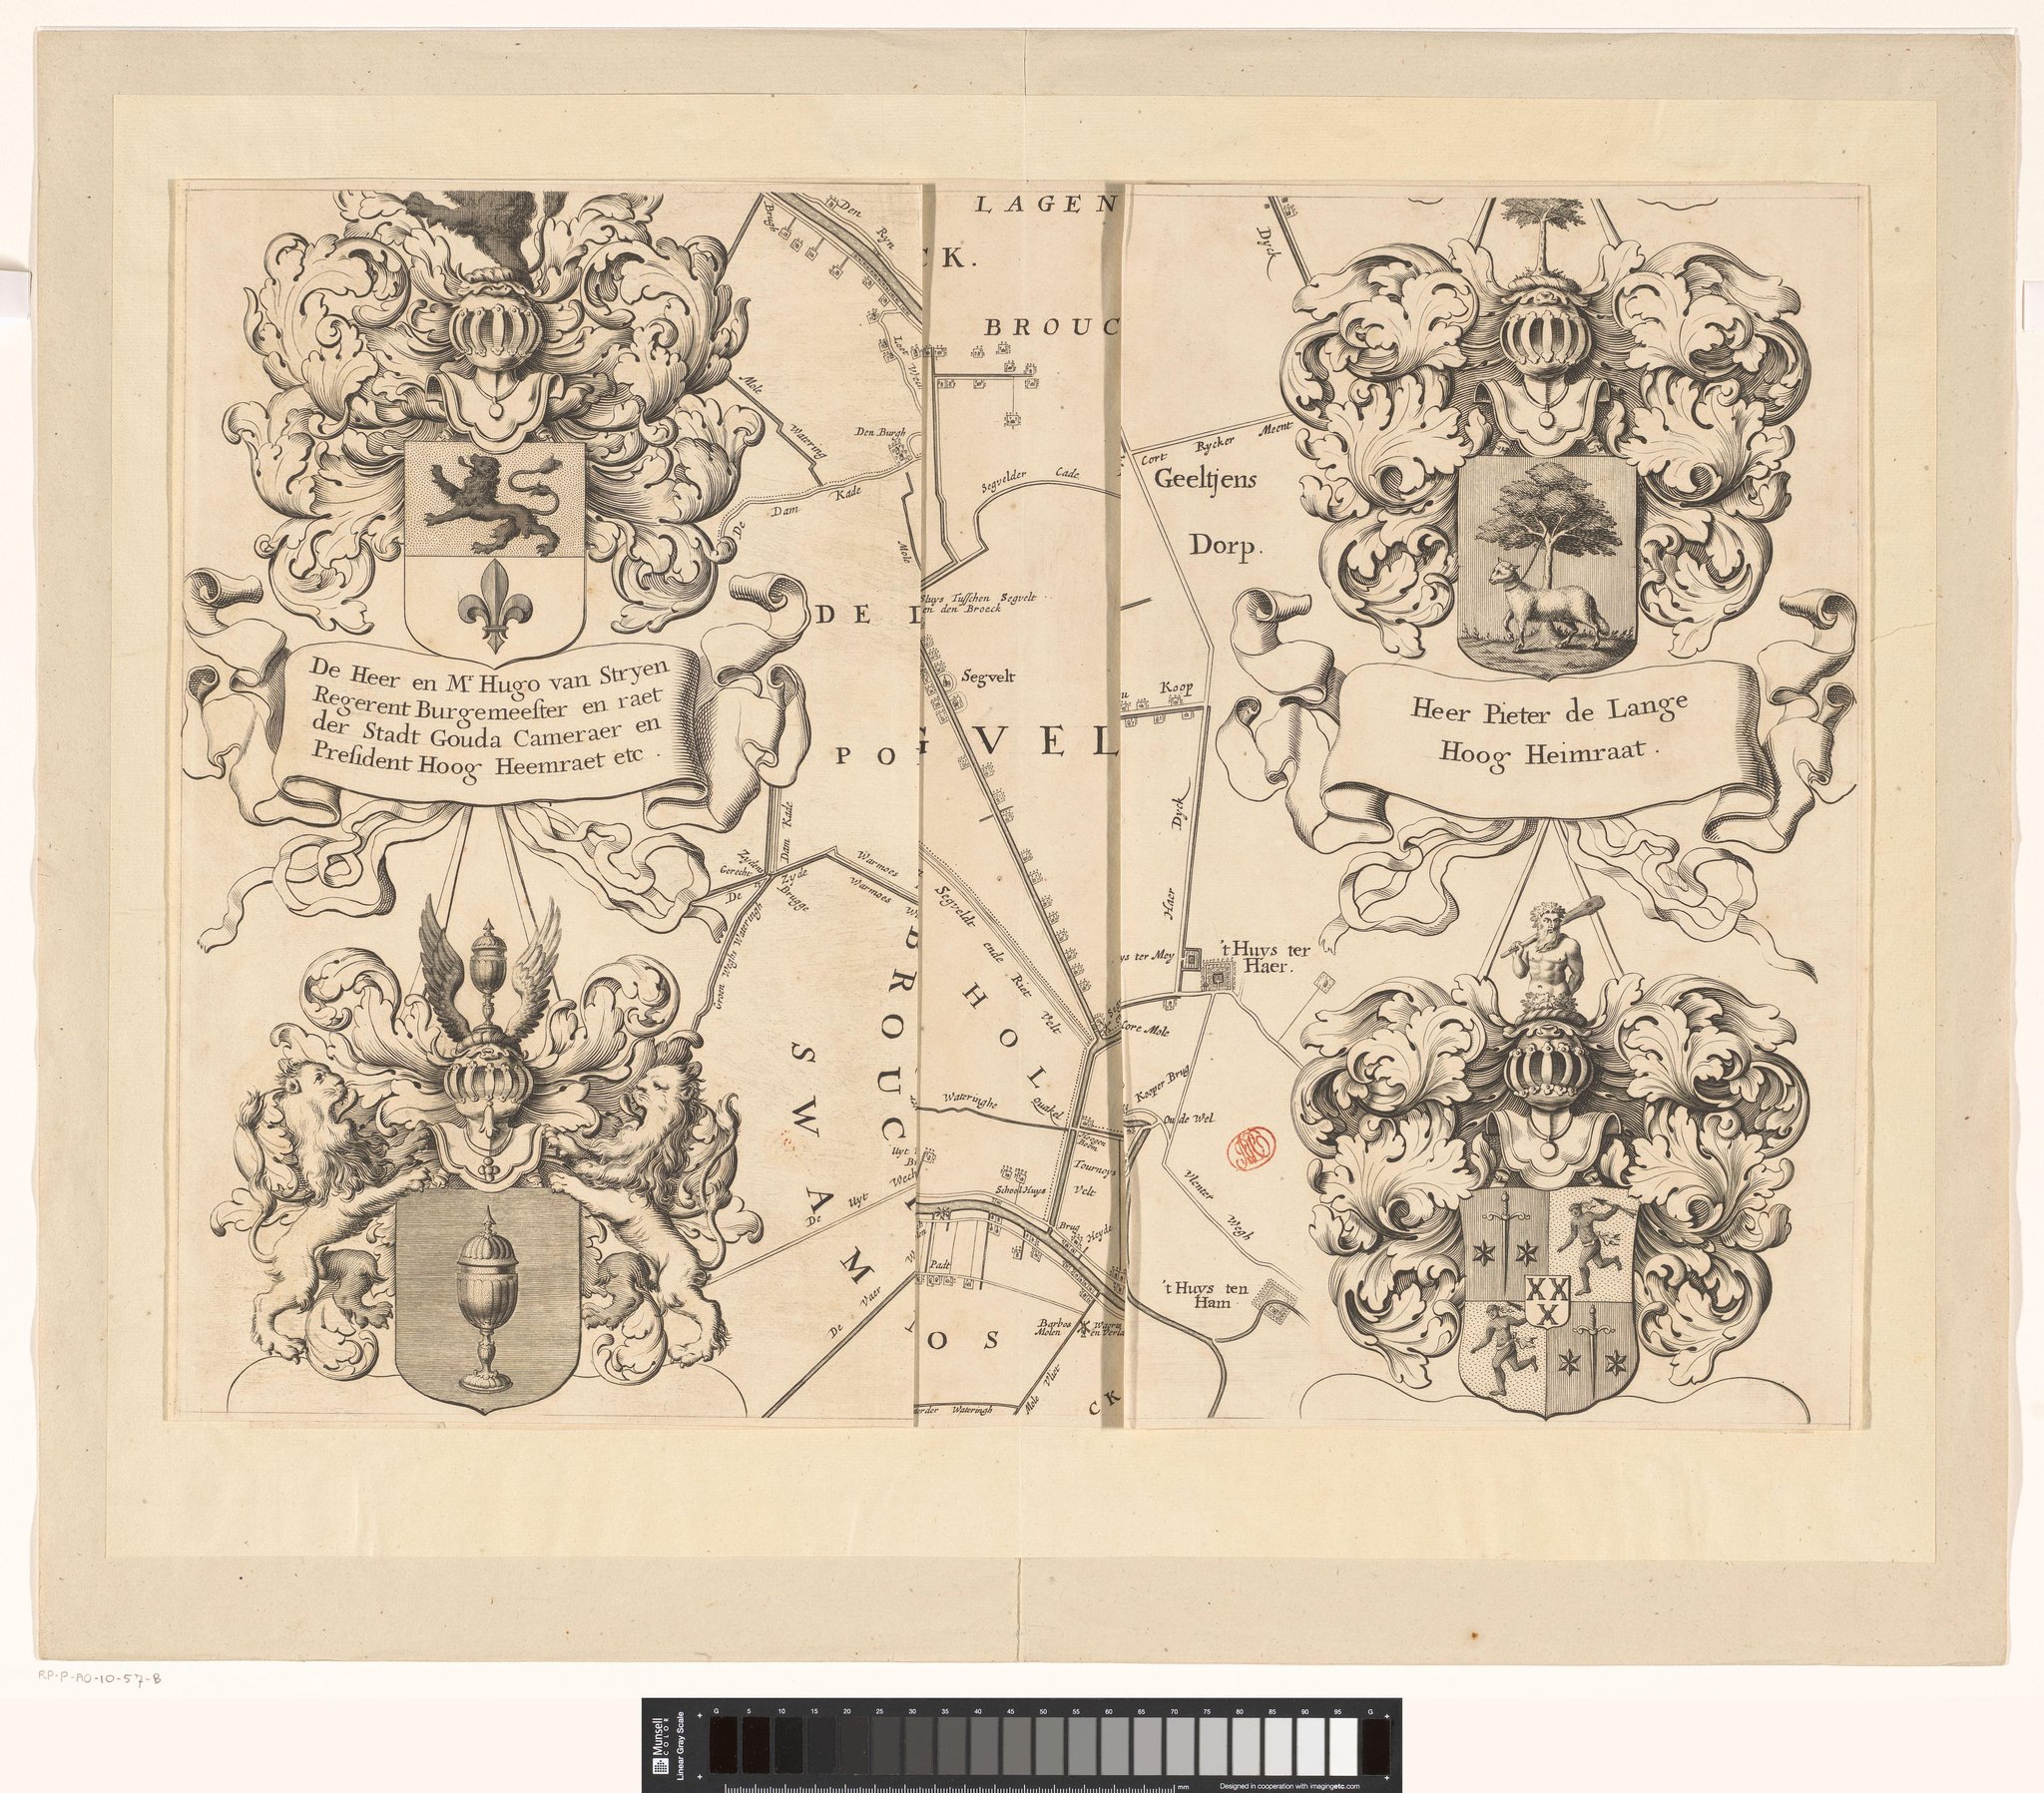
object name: print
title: Kaart van het Hoogheemraadschap van Woerden (middelste deel)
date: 1670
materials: paper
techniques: engraving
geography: amsterdam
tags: maps of separate countries or regions, armorial bearing, heraldry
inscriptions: collector's mark: Lugt 195, collector's mark: Lugt 2228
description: Middelste deel van een kaart van het Hoogheemraadschap van Woerden.